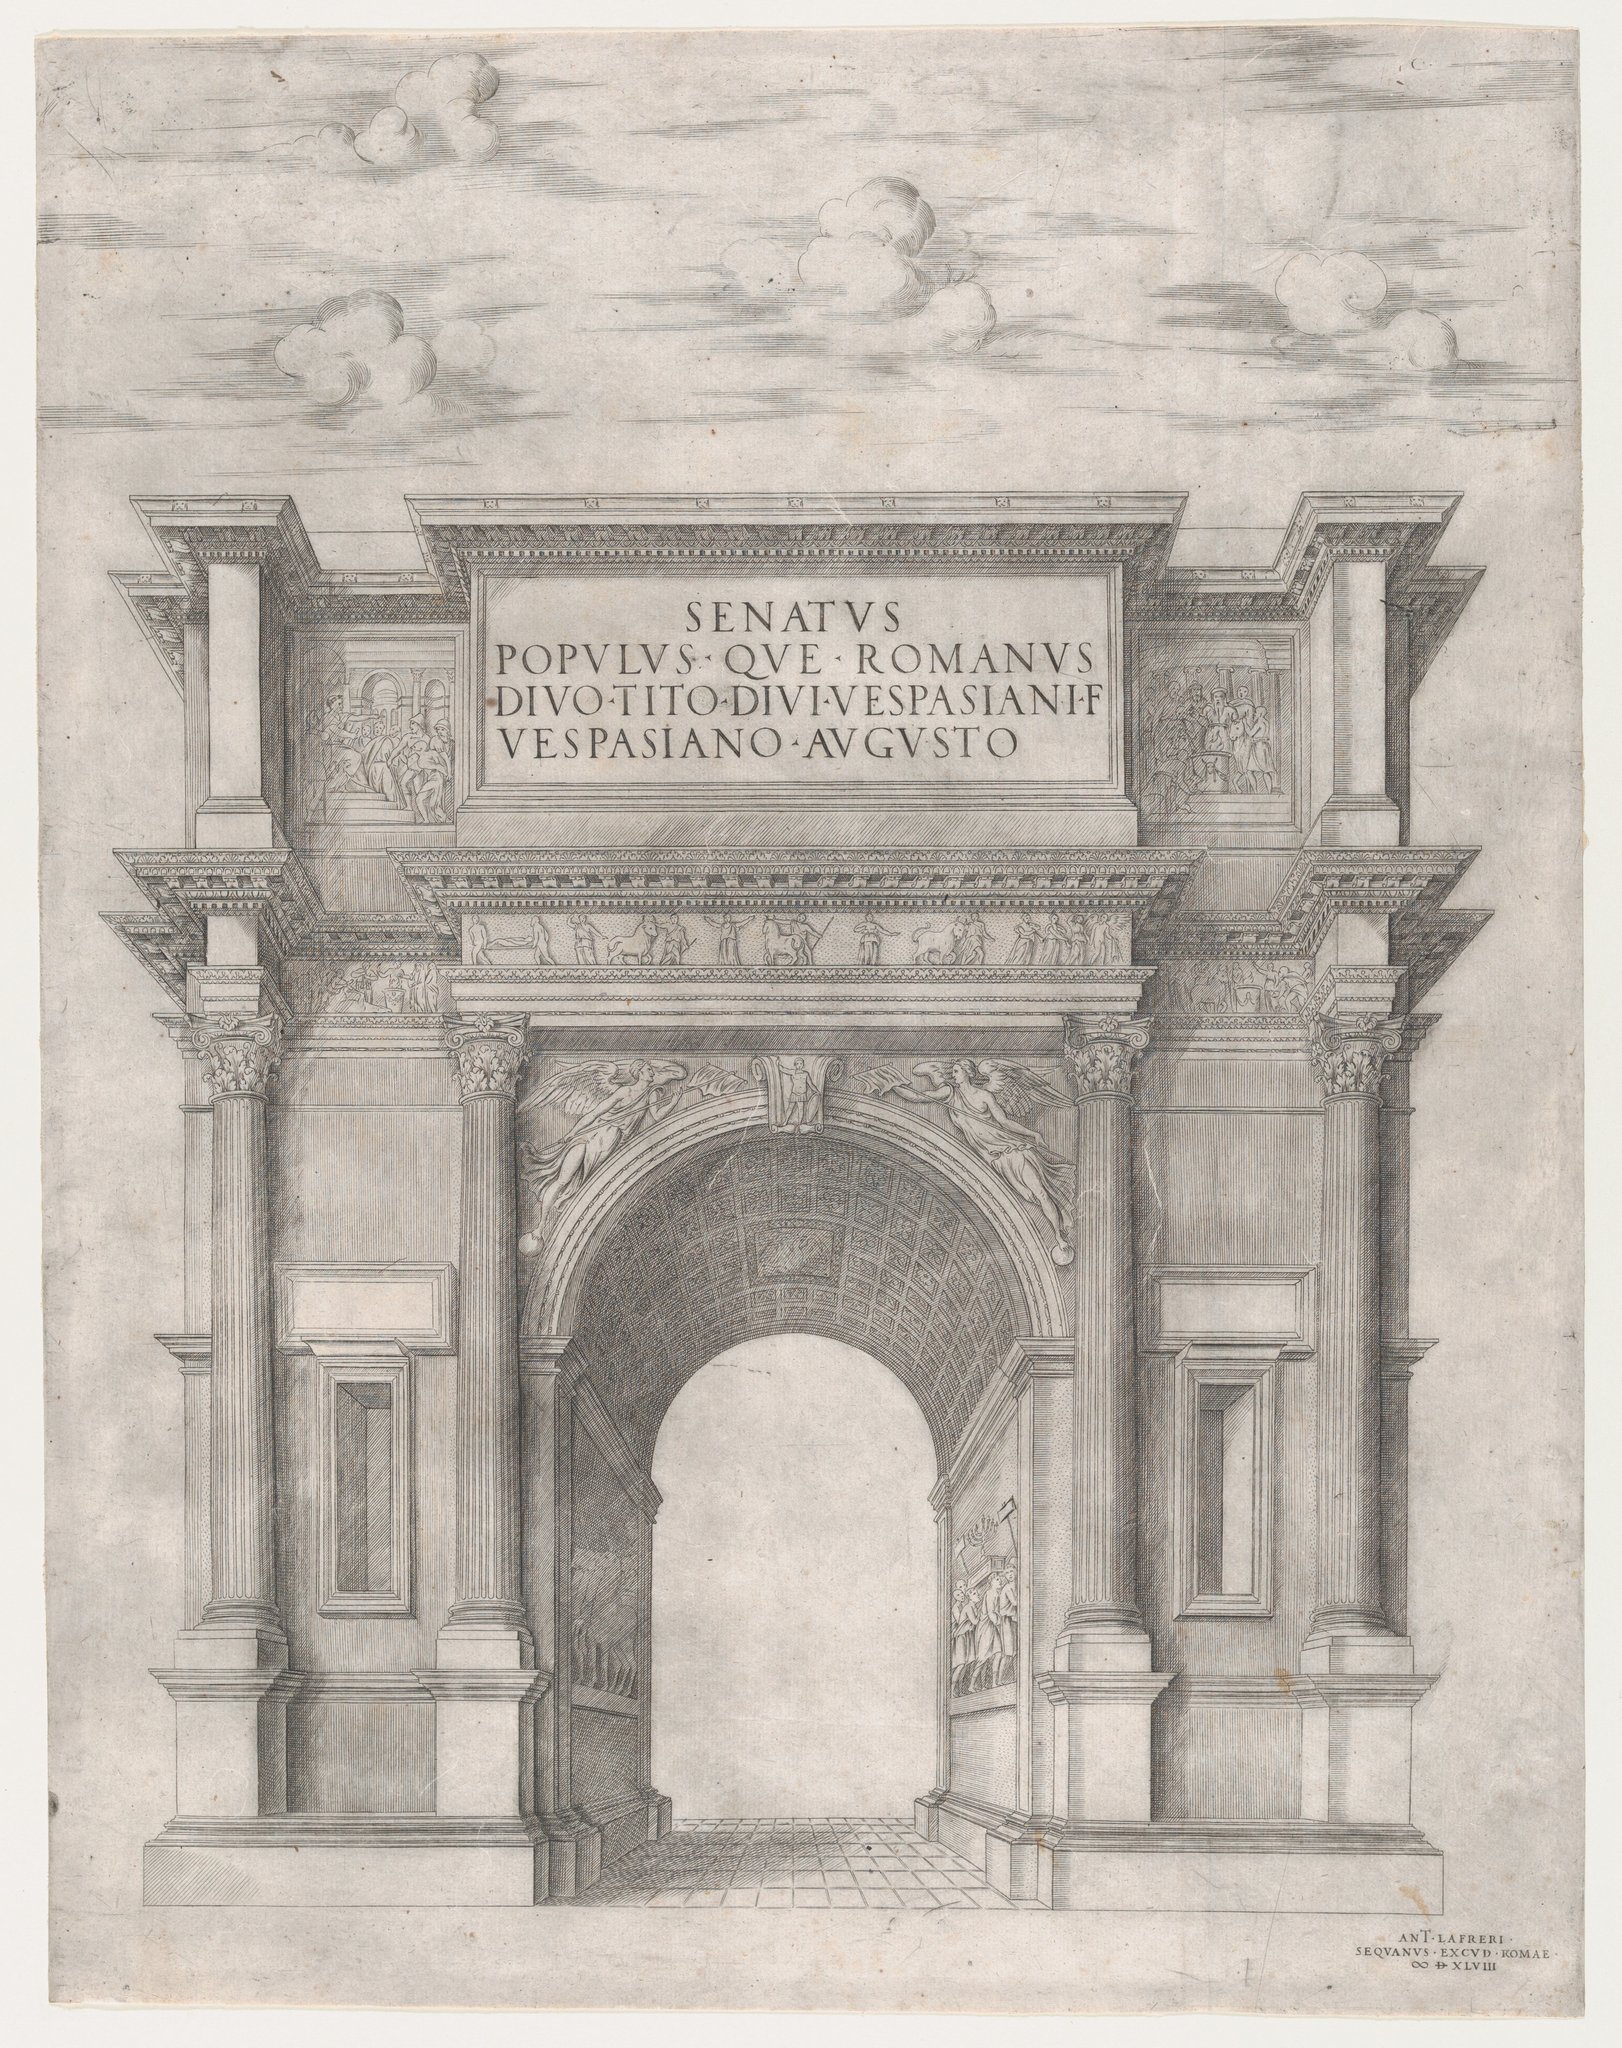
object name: print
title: Arch of Titus, from "Speculum Romanae Magnificentiae"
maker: Anonymous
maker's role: artist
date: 1558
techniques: engraving, etching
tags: architecture,arches,rome